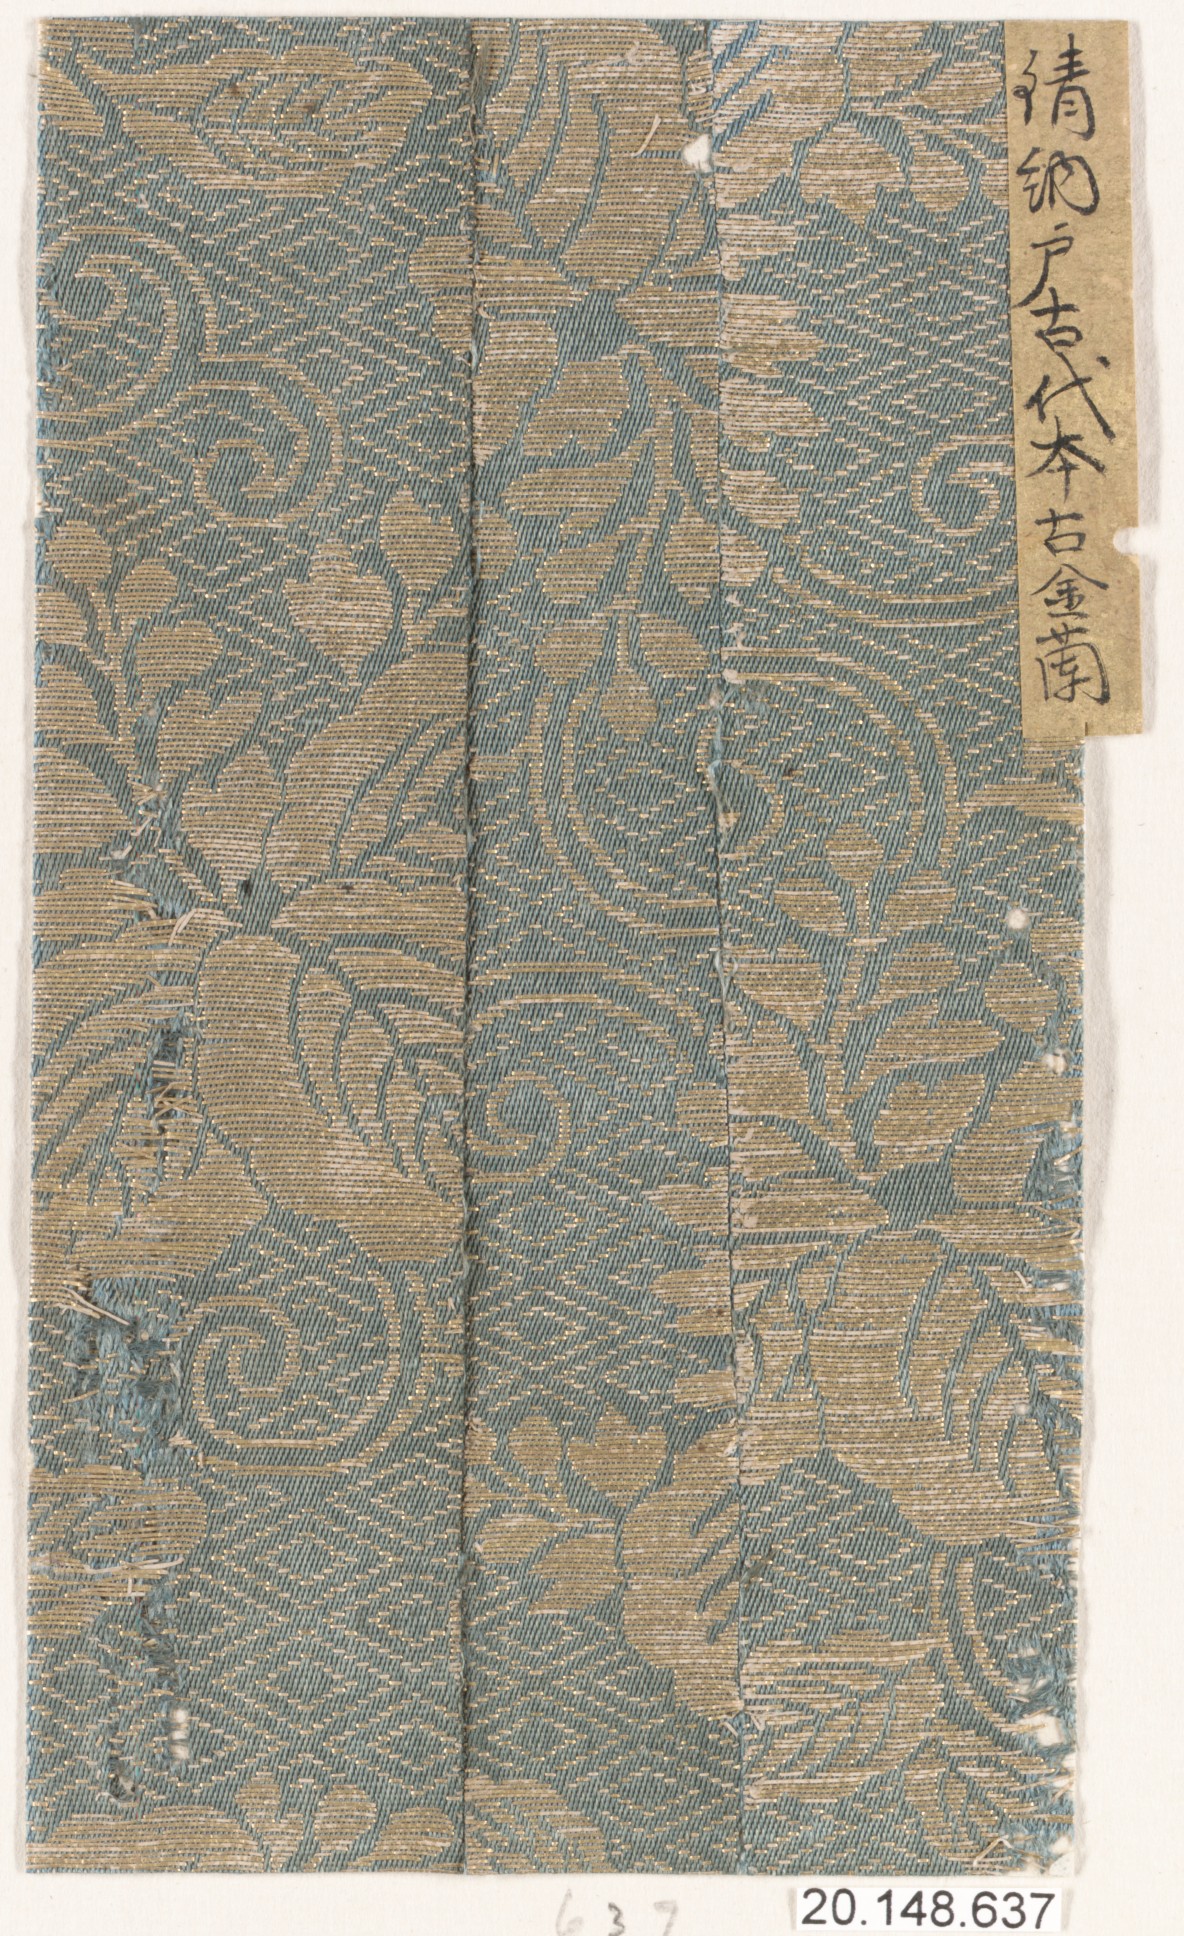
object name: piece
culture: japanese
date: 1601-1700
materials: silk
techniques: compound weave